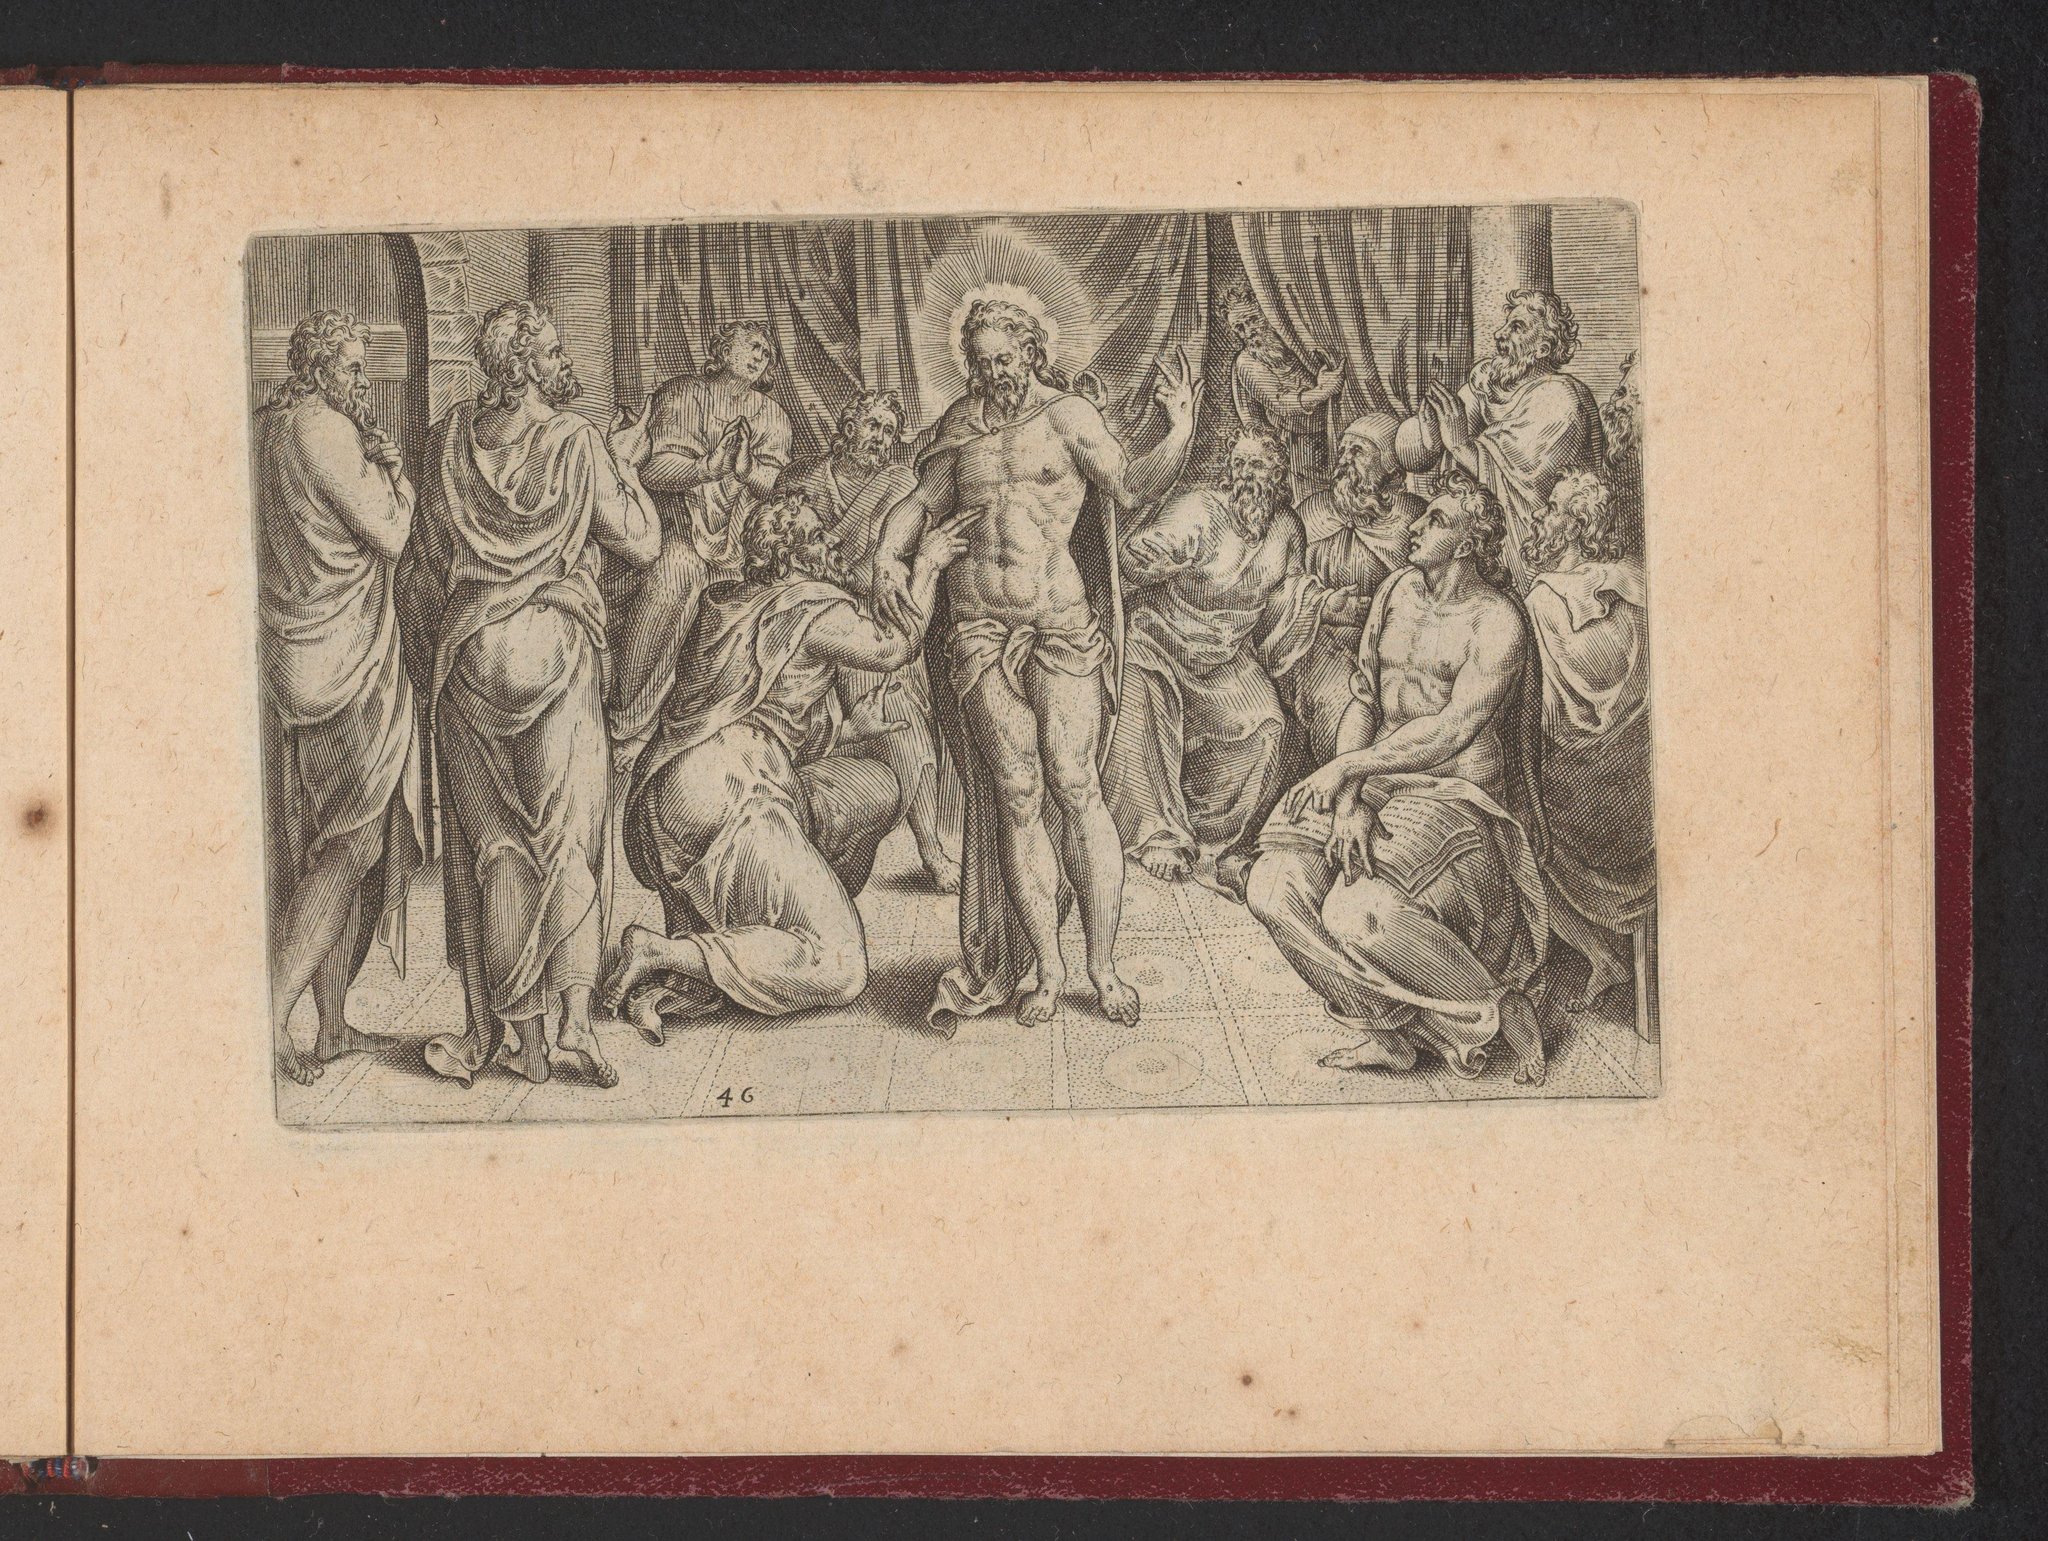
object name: print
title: Christi Iesu vitae admirabiliumque actionum speculum a Philippo Gallaeo apparatum Bened. Ariae Montani singuloribus distichis instructum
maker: philips galle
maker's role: print maker, publisher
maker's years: 1537-1612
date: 1573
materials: paper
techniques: engraving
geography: antwerp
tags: thomas touching or stretching out his hands to touch the wound in christ's side, sometimes christ leading thomas' hand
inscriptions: watermark: ‘gotische letter P’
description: Onderdeel van een album met een titelprent en een serie van 50 prenten betreffende het leven en de passie van Christus.